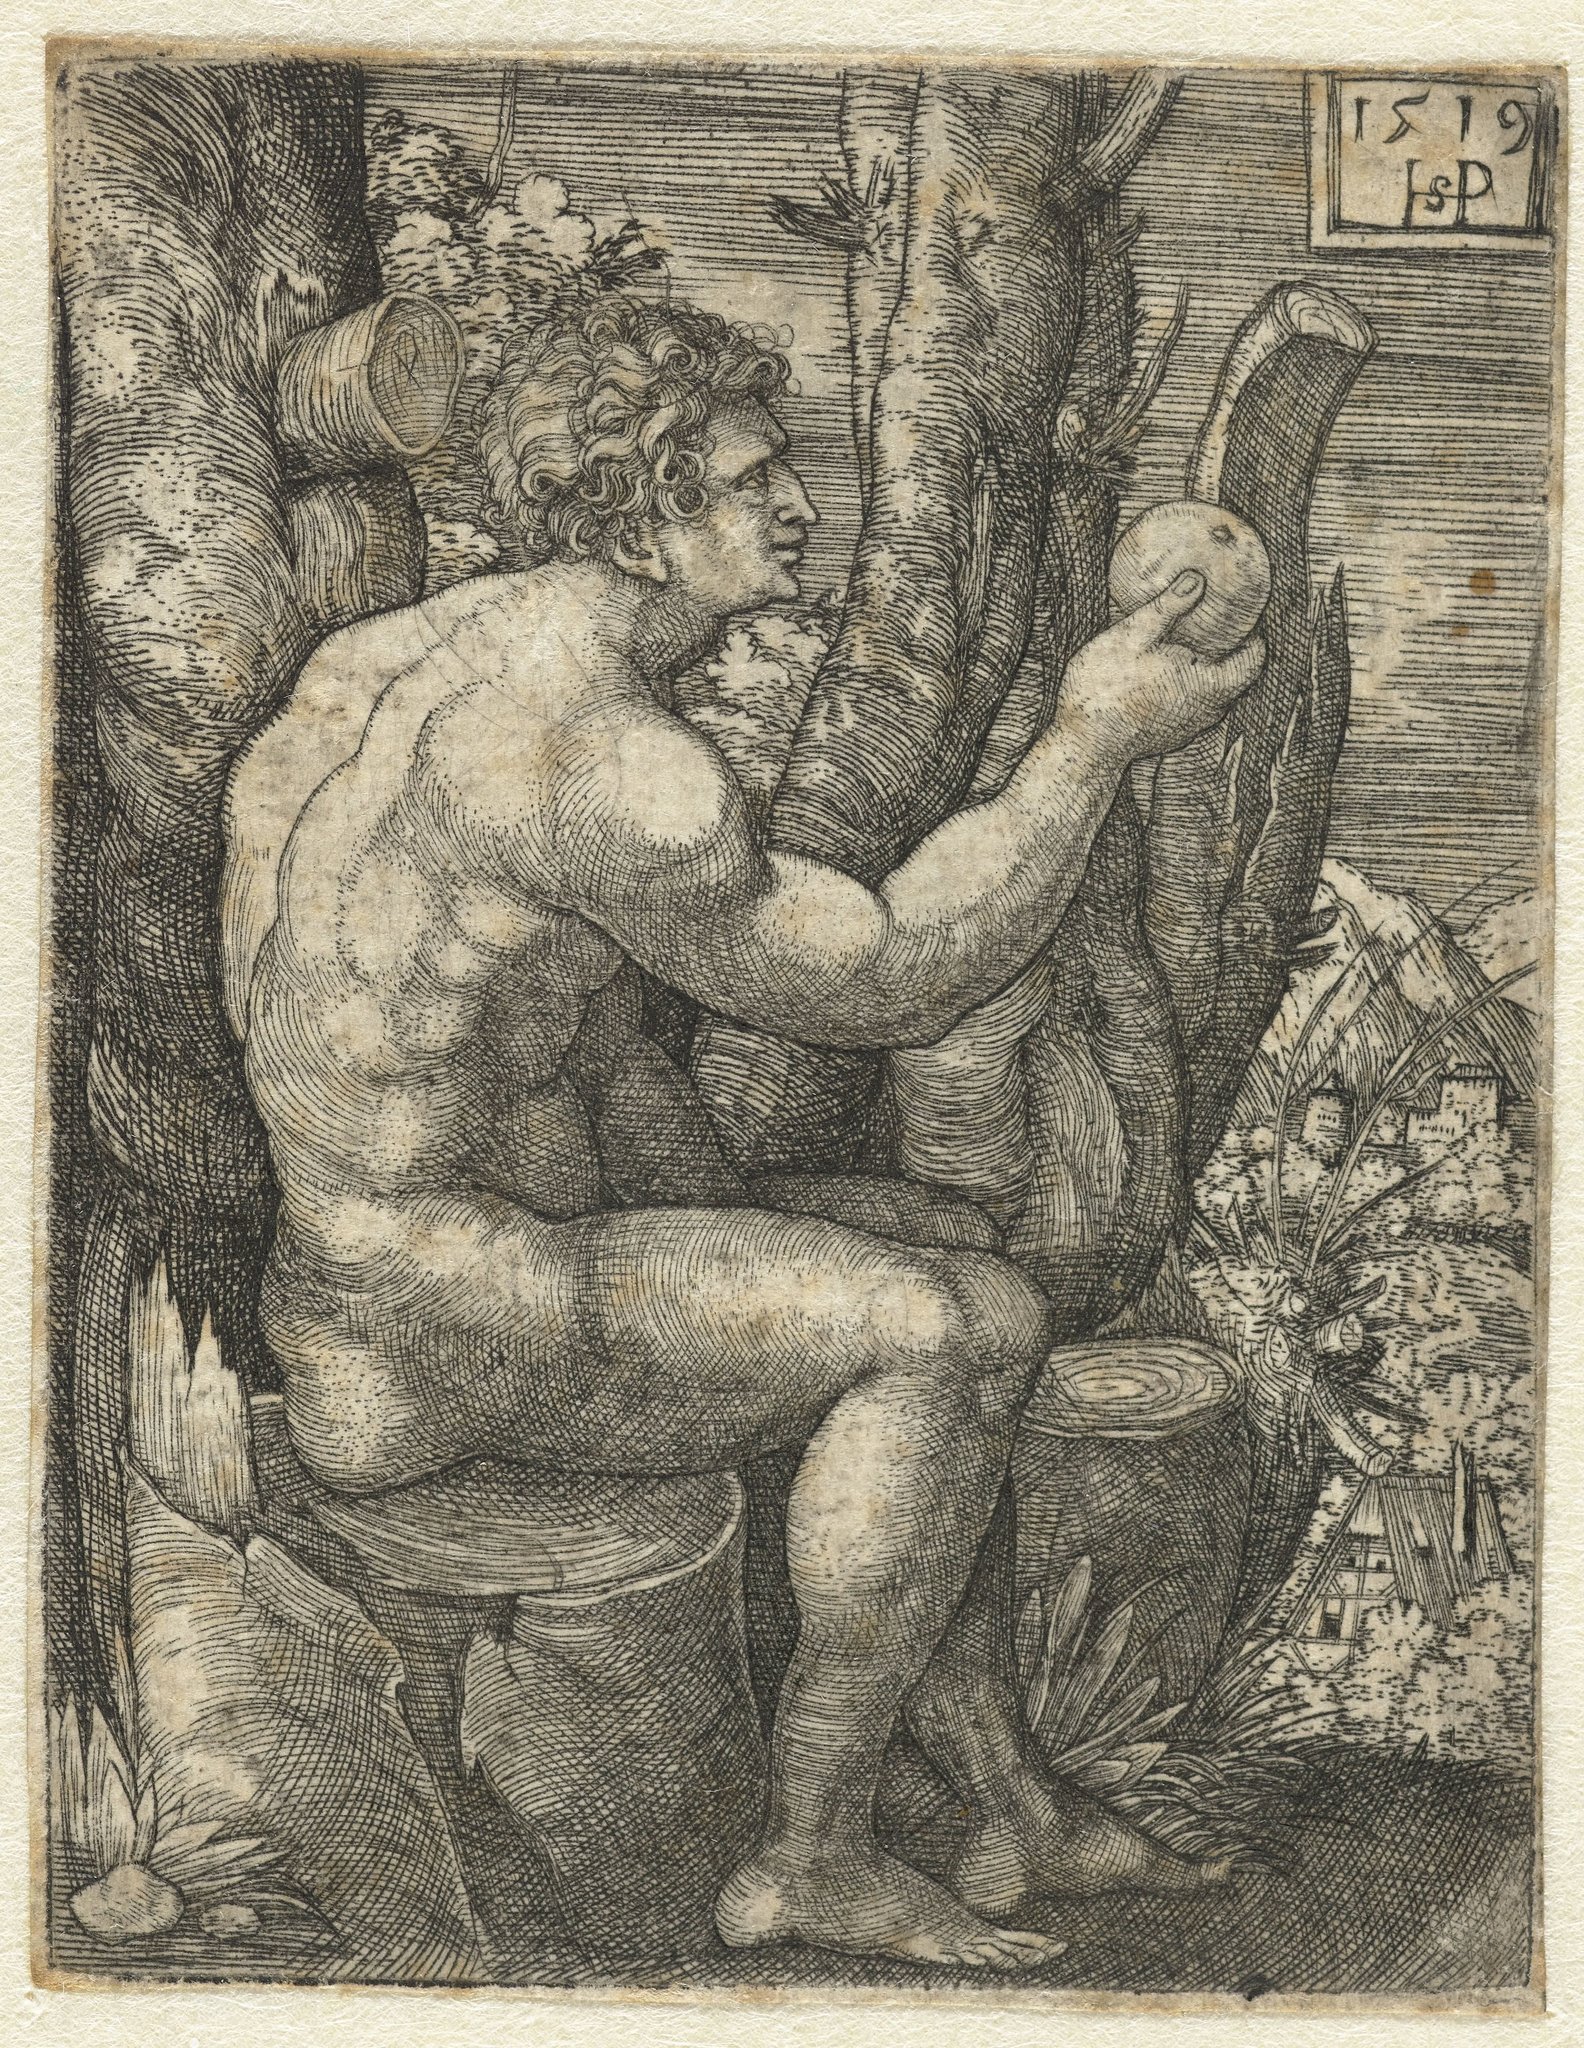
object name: print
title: Adam zittend op boomstronk met appel in zijn hand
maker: hans sebald beham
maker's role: designer, draughtsman, print maker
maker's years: 1500-1550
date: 1519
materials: paper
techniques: engraving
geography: nuremberg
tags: adam (not in biblical context)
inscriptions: collector's mark: Lugt 240